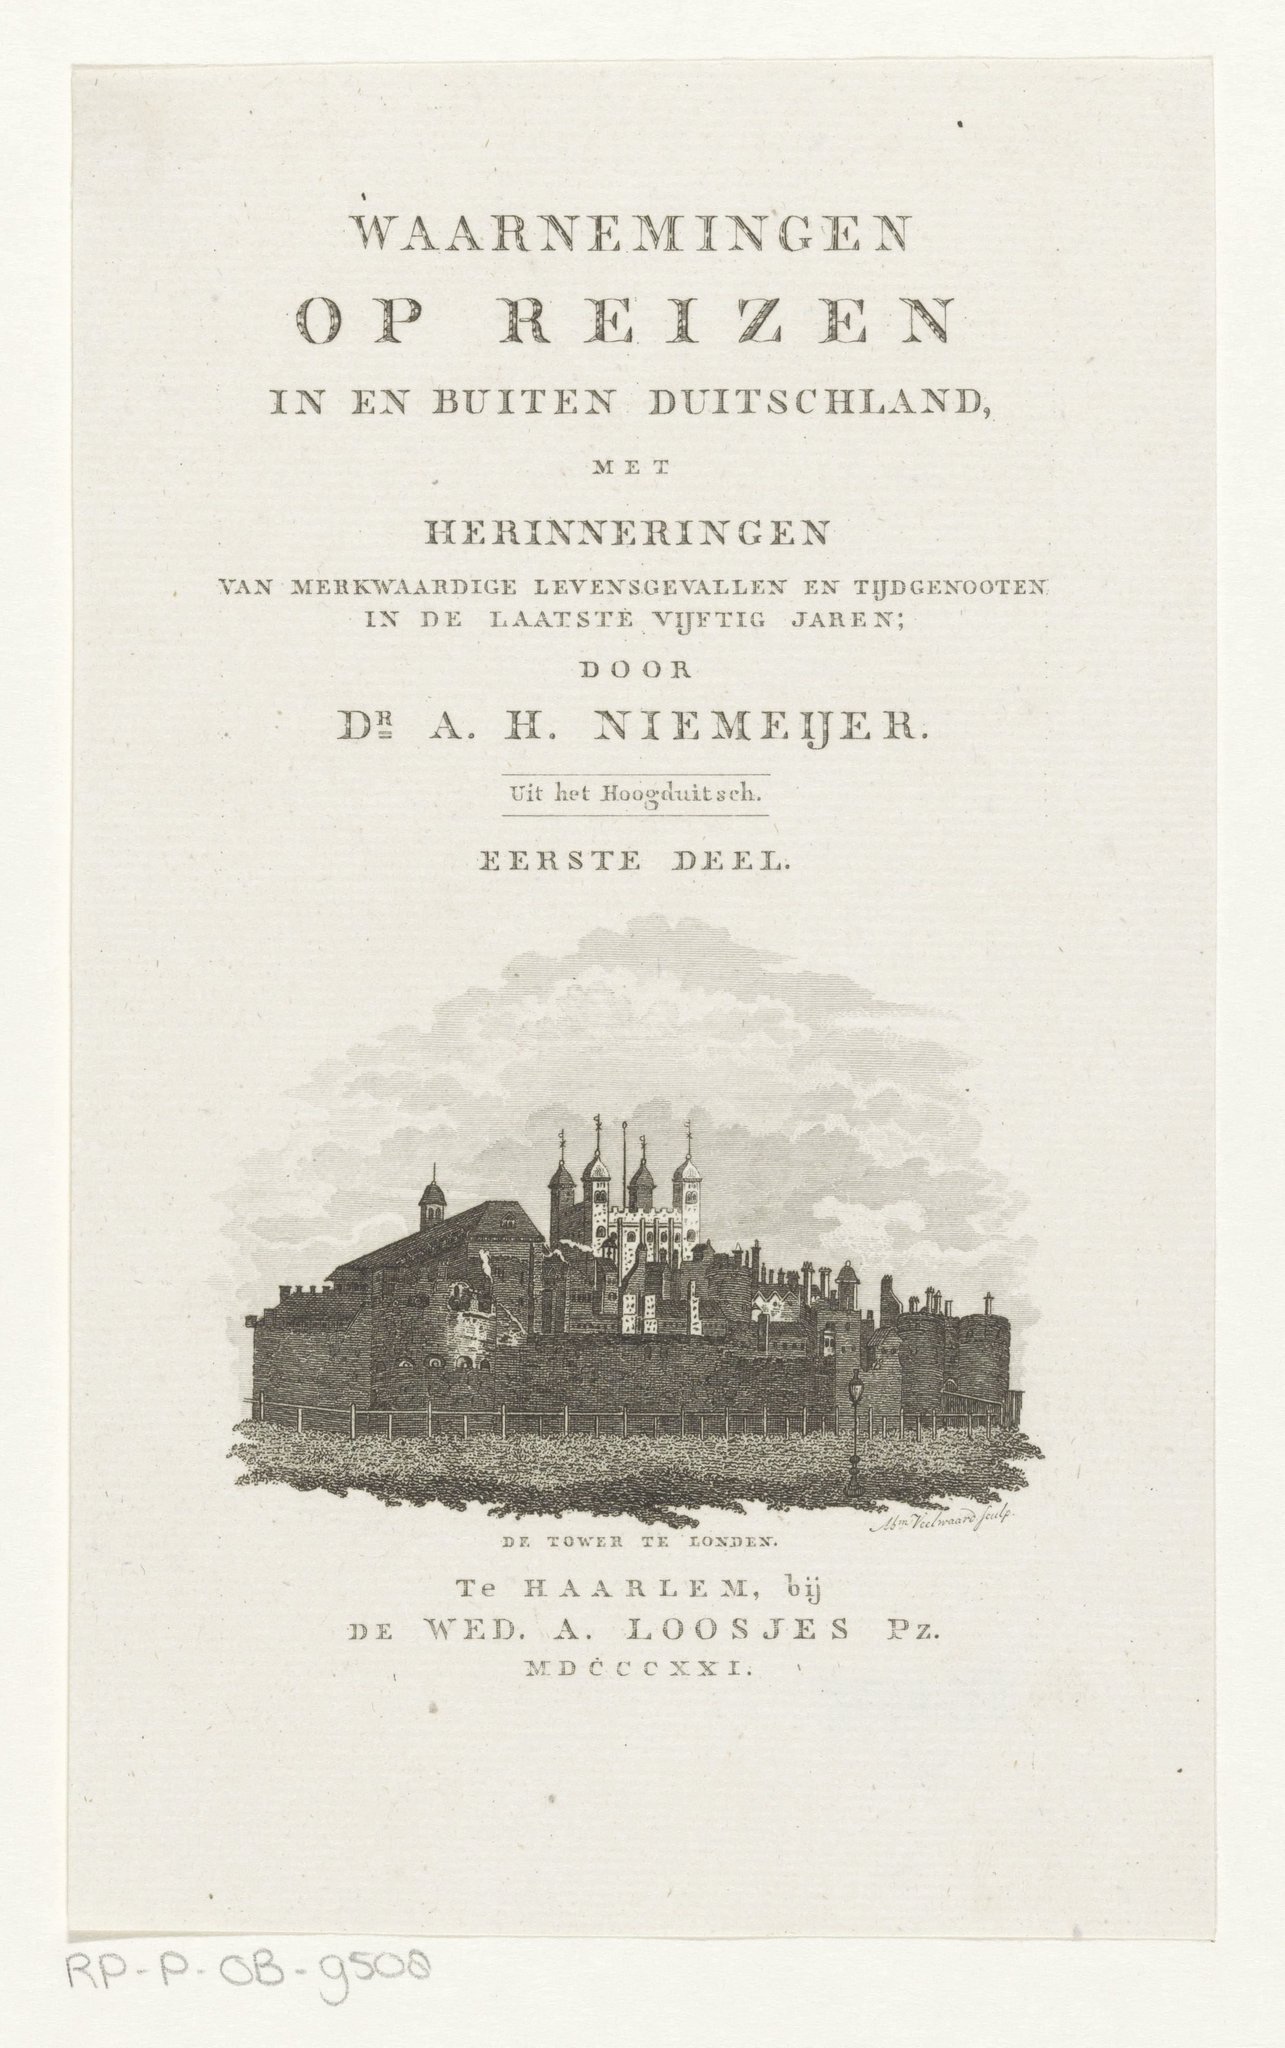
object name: titelblad, titelpagina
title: Titelpagina voor: A.H. Niemeyer, Waarnemingen op Reizen in en buiten Deutschland, 1821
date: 1821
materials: paper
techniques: engraving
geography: haarlem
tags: landscape with tower or castle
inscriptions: collector's mark: Lugt 2228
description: Titelpagina voor: Niemeyer, A.H. Waarnemingen op Reizen in en buiten Deutschland met herinneringen, eerste deel. Haarlem: Loosjes Pz., weduwe Adriaan, 1821.